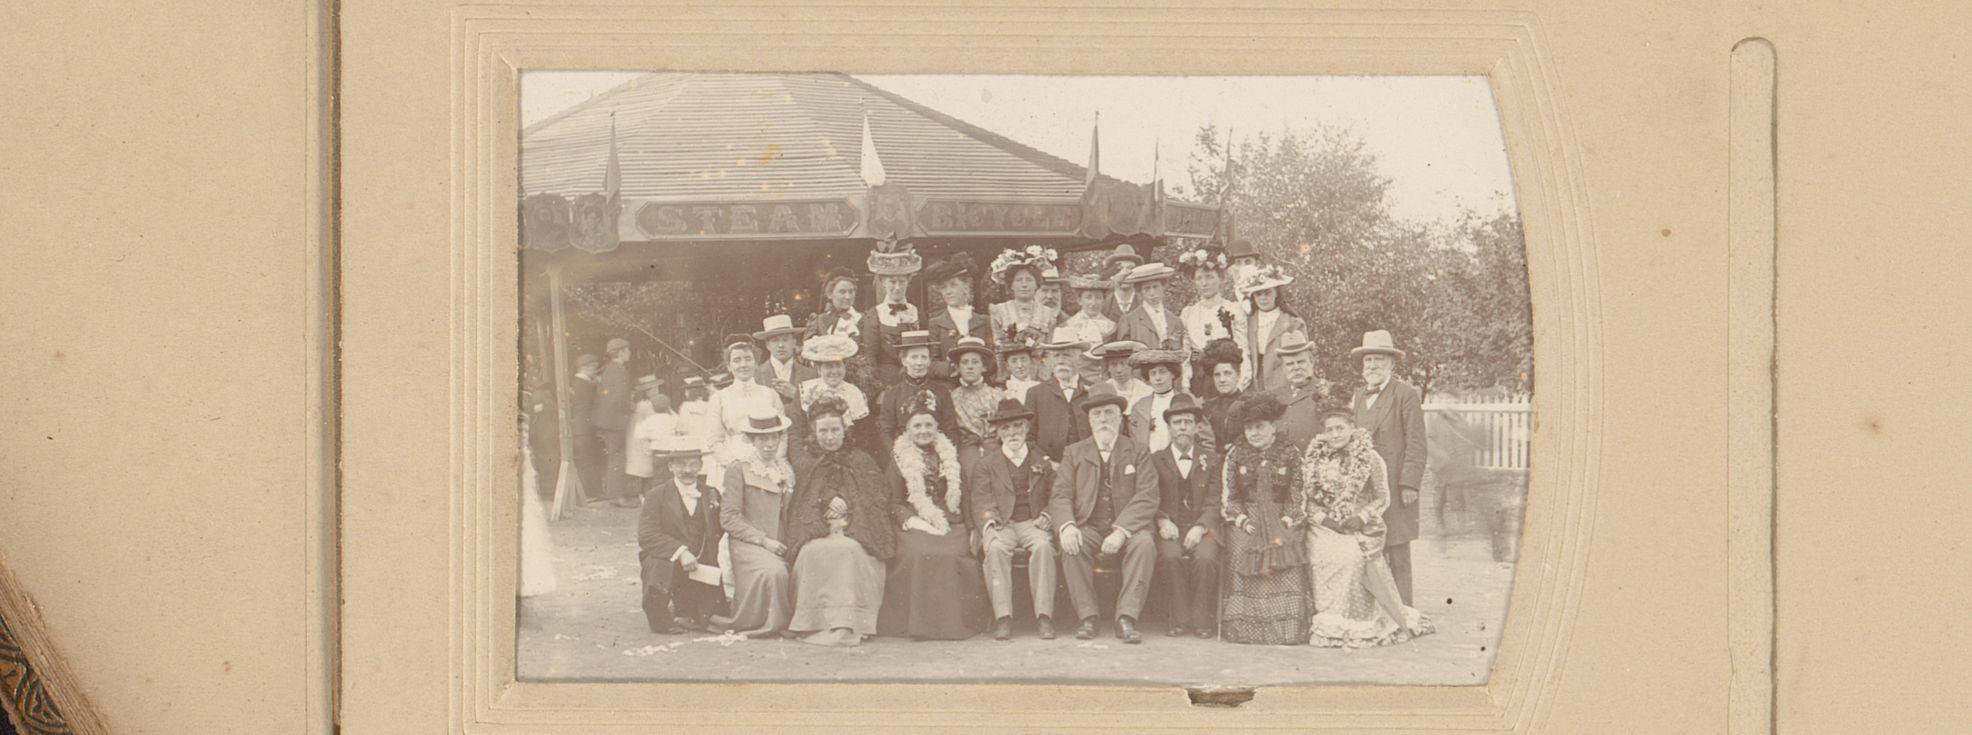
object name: photograph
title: Groepsportret van een gezelschap op de kermis voor een Steam Bicycle tent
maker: john h. williams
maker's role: fotograaf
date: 1880-1920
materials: cardboard, photographic support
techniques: gelatin silver print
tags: pleasure fair and circus, anonymous historical persons portrayed in a group, in a group-portrait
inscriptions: inscription: ‘John H. Williams/ Phototgrapher/ 42. Hornbey Park [...] London’